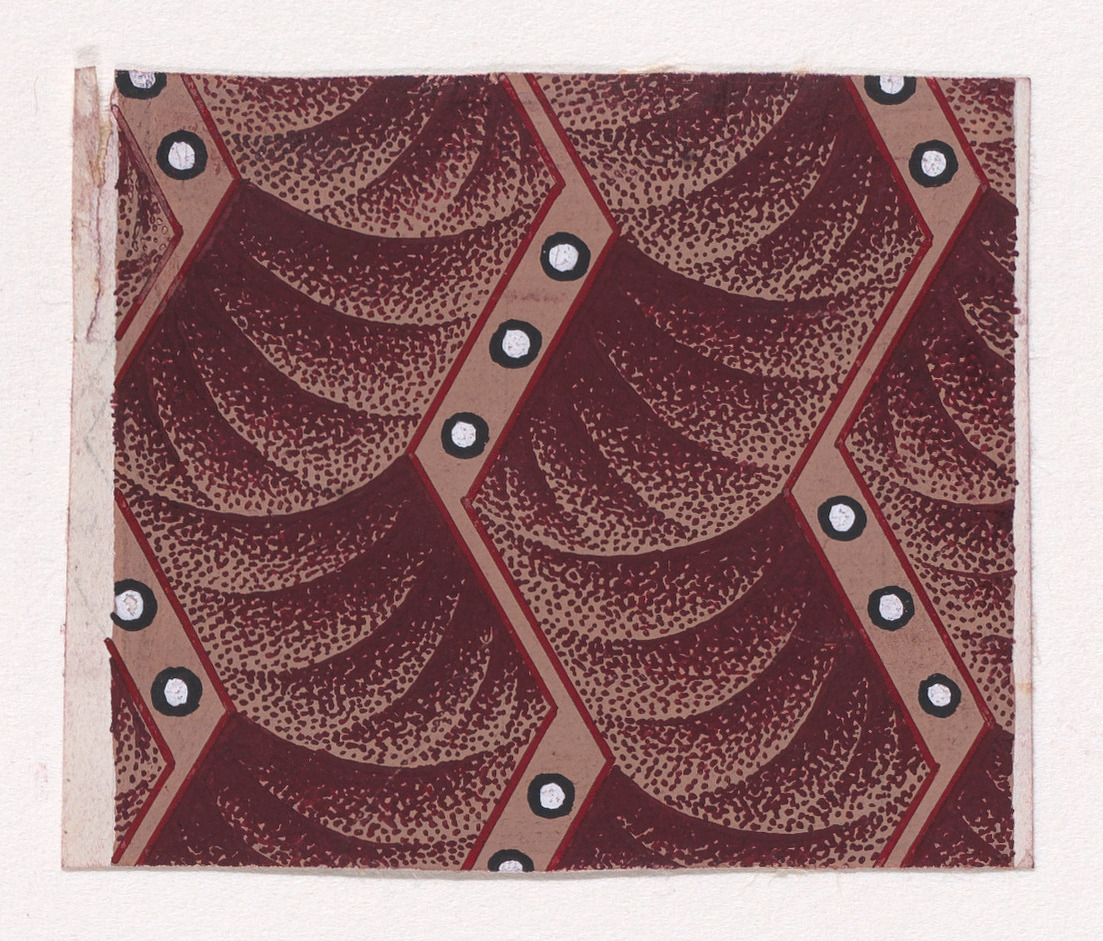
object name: drawing ornament architecture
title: Textile Design with Vertical Strips of Zig-Zagging Ribbons Decorated with Pearls over a Background of Overlapping Scales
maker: anonymous, alsatian, 19th century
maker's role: artist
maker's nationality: alsatian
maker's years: 1800-1900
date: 1840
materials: gouache